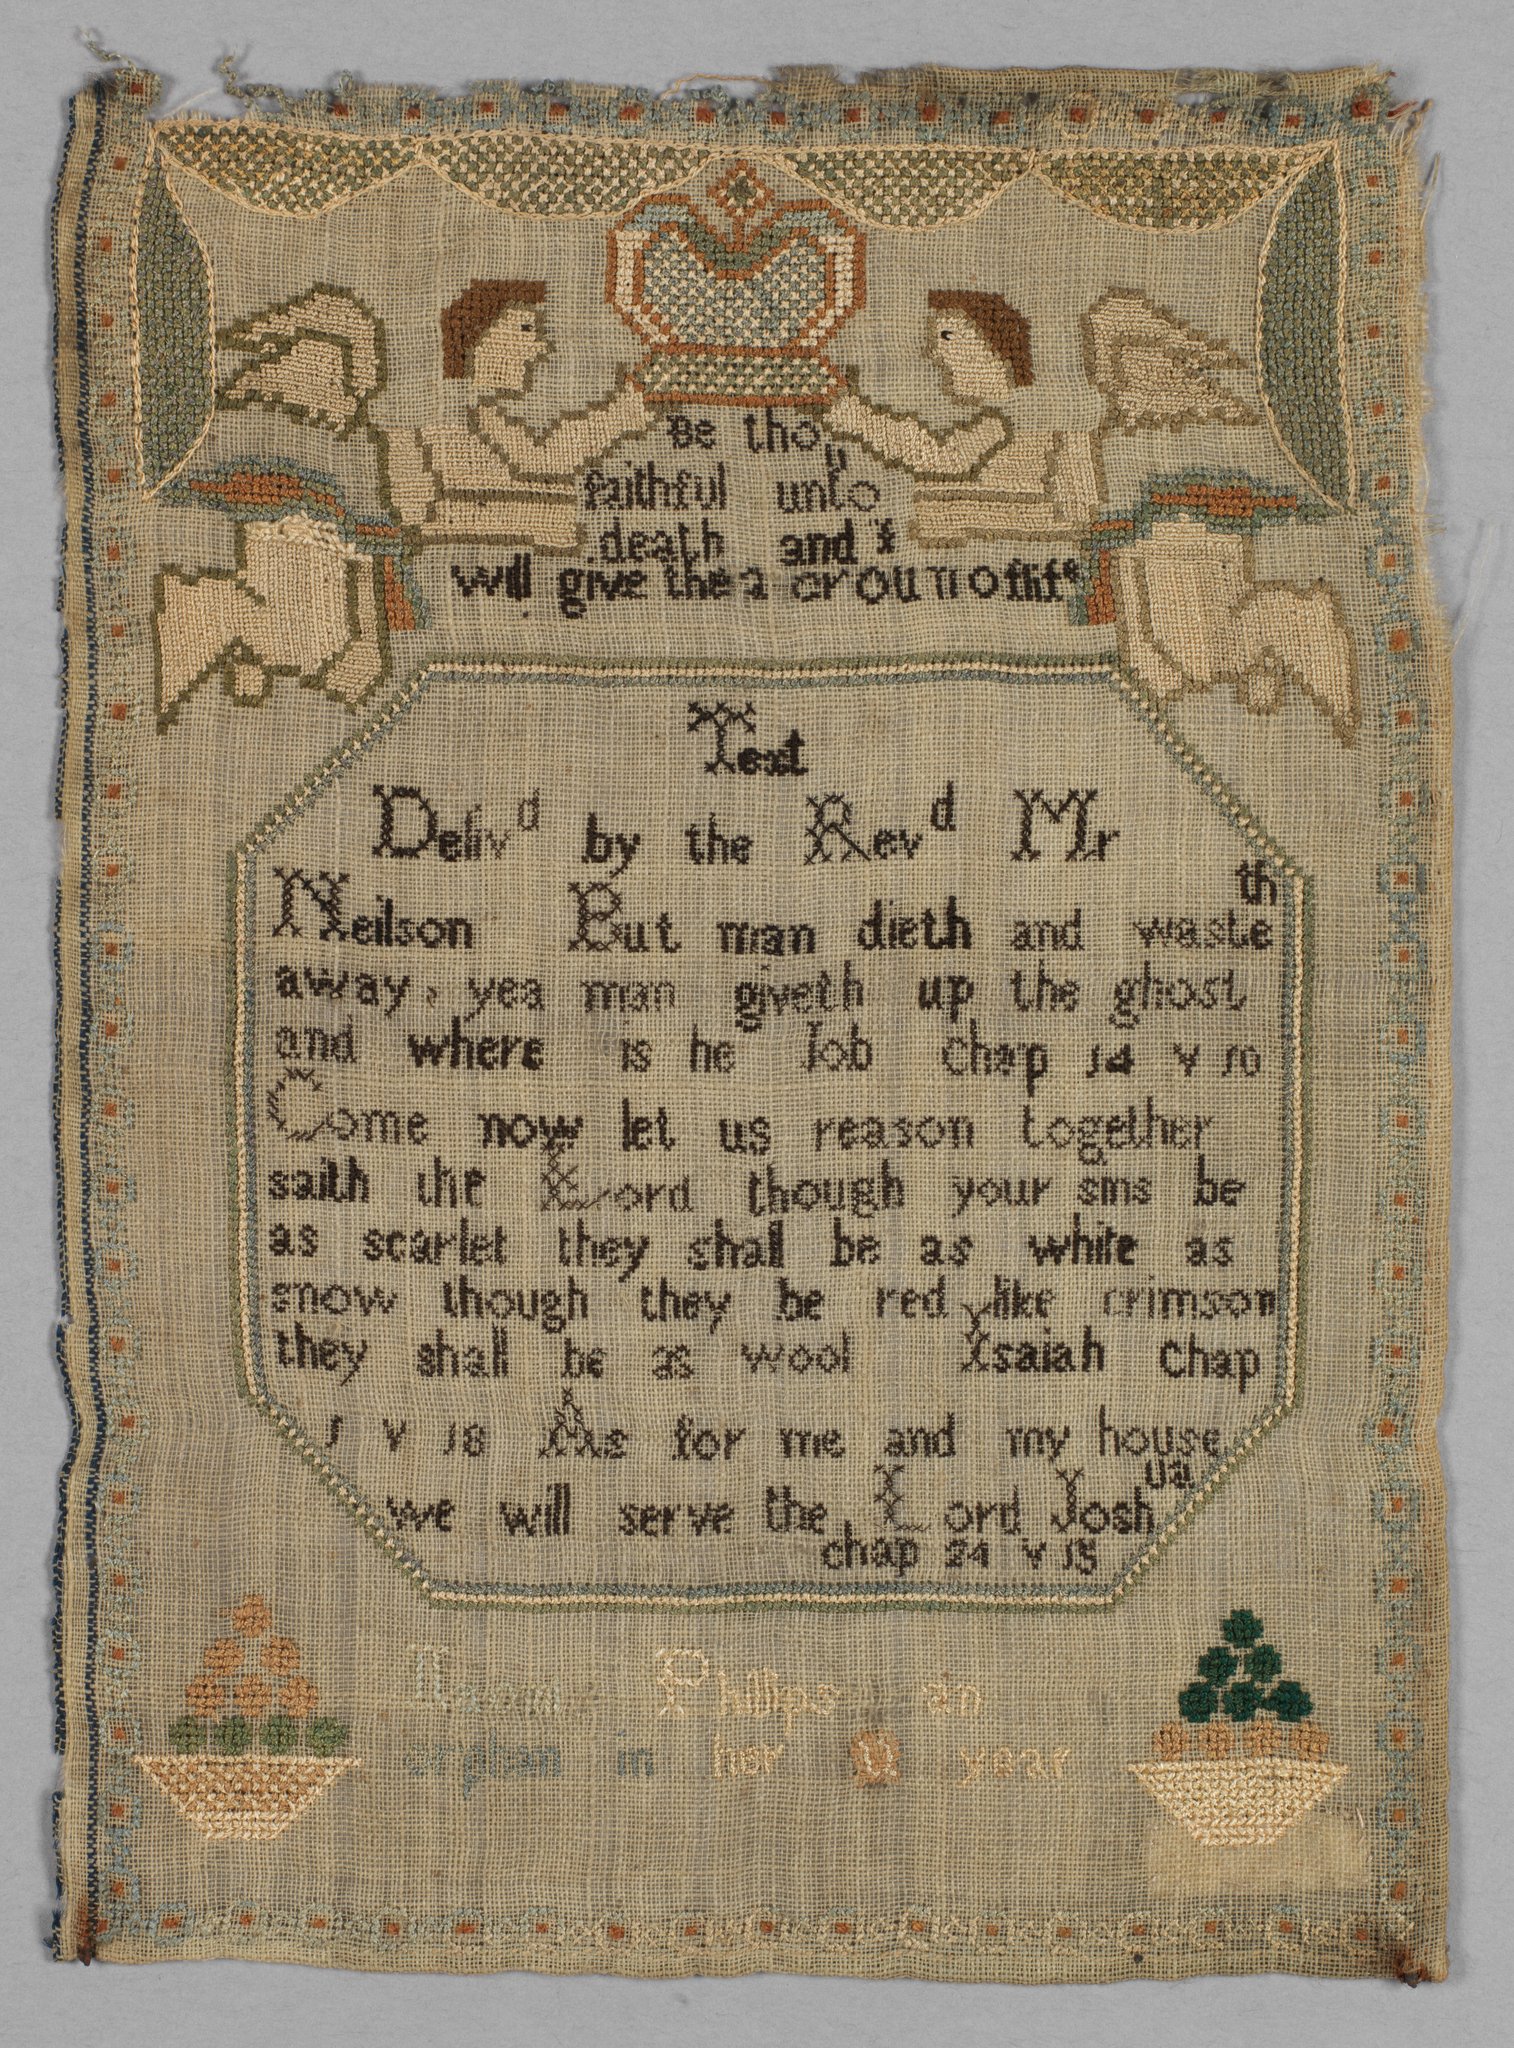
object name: sampler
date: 1801-1900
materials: canvas, silk, wool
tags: angels